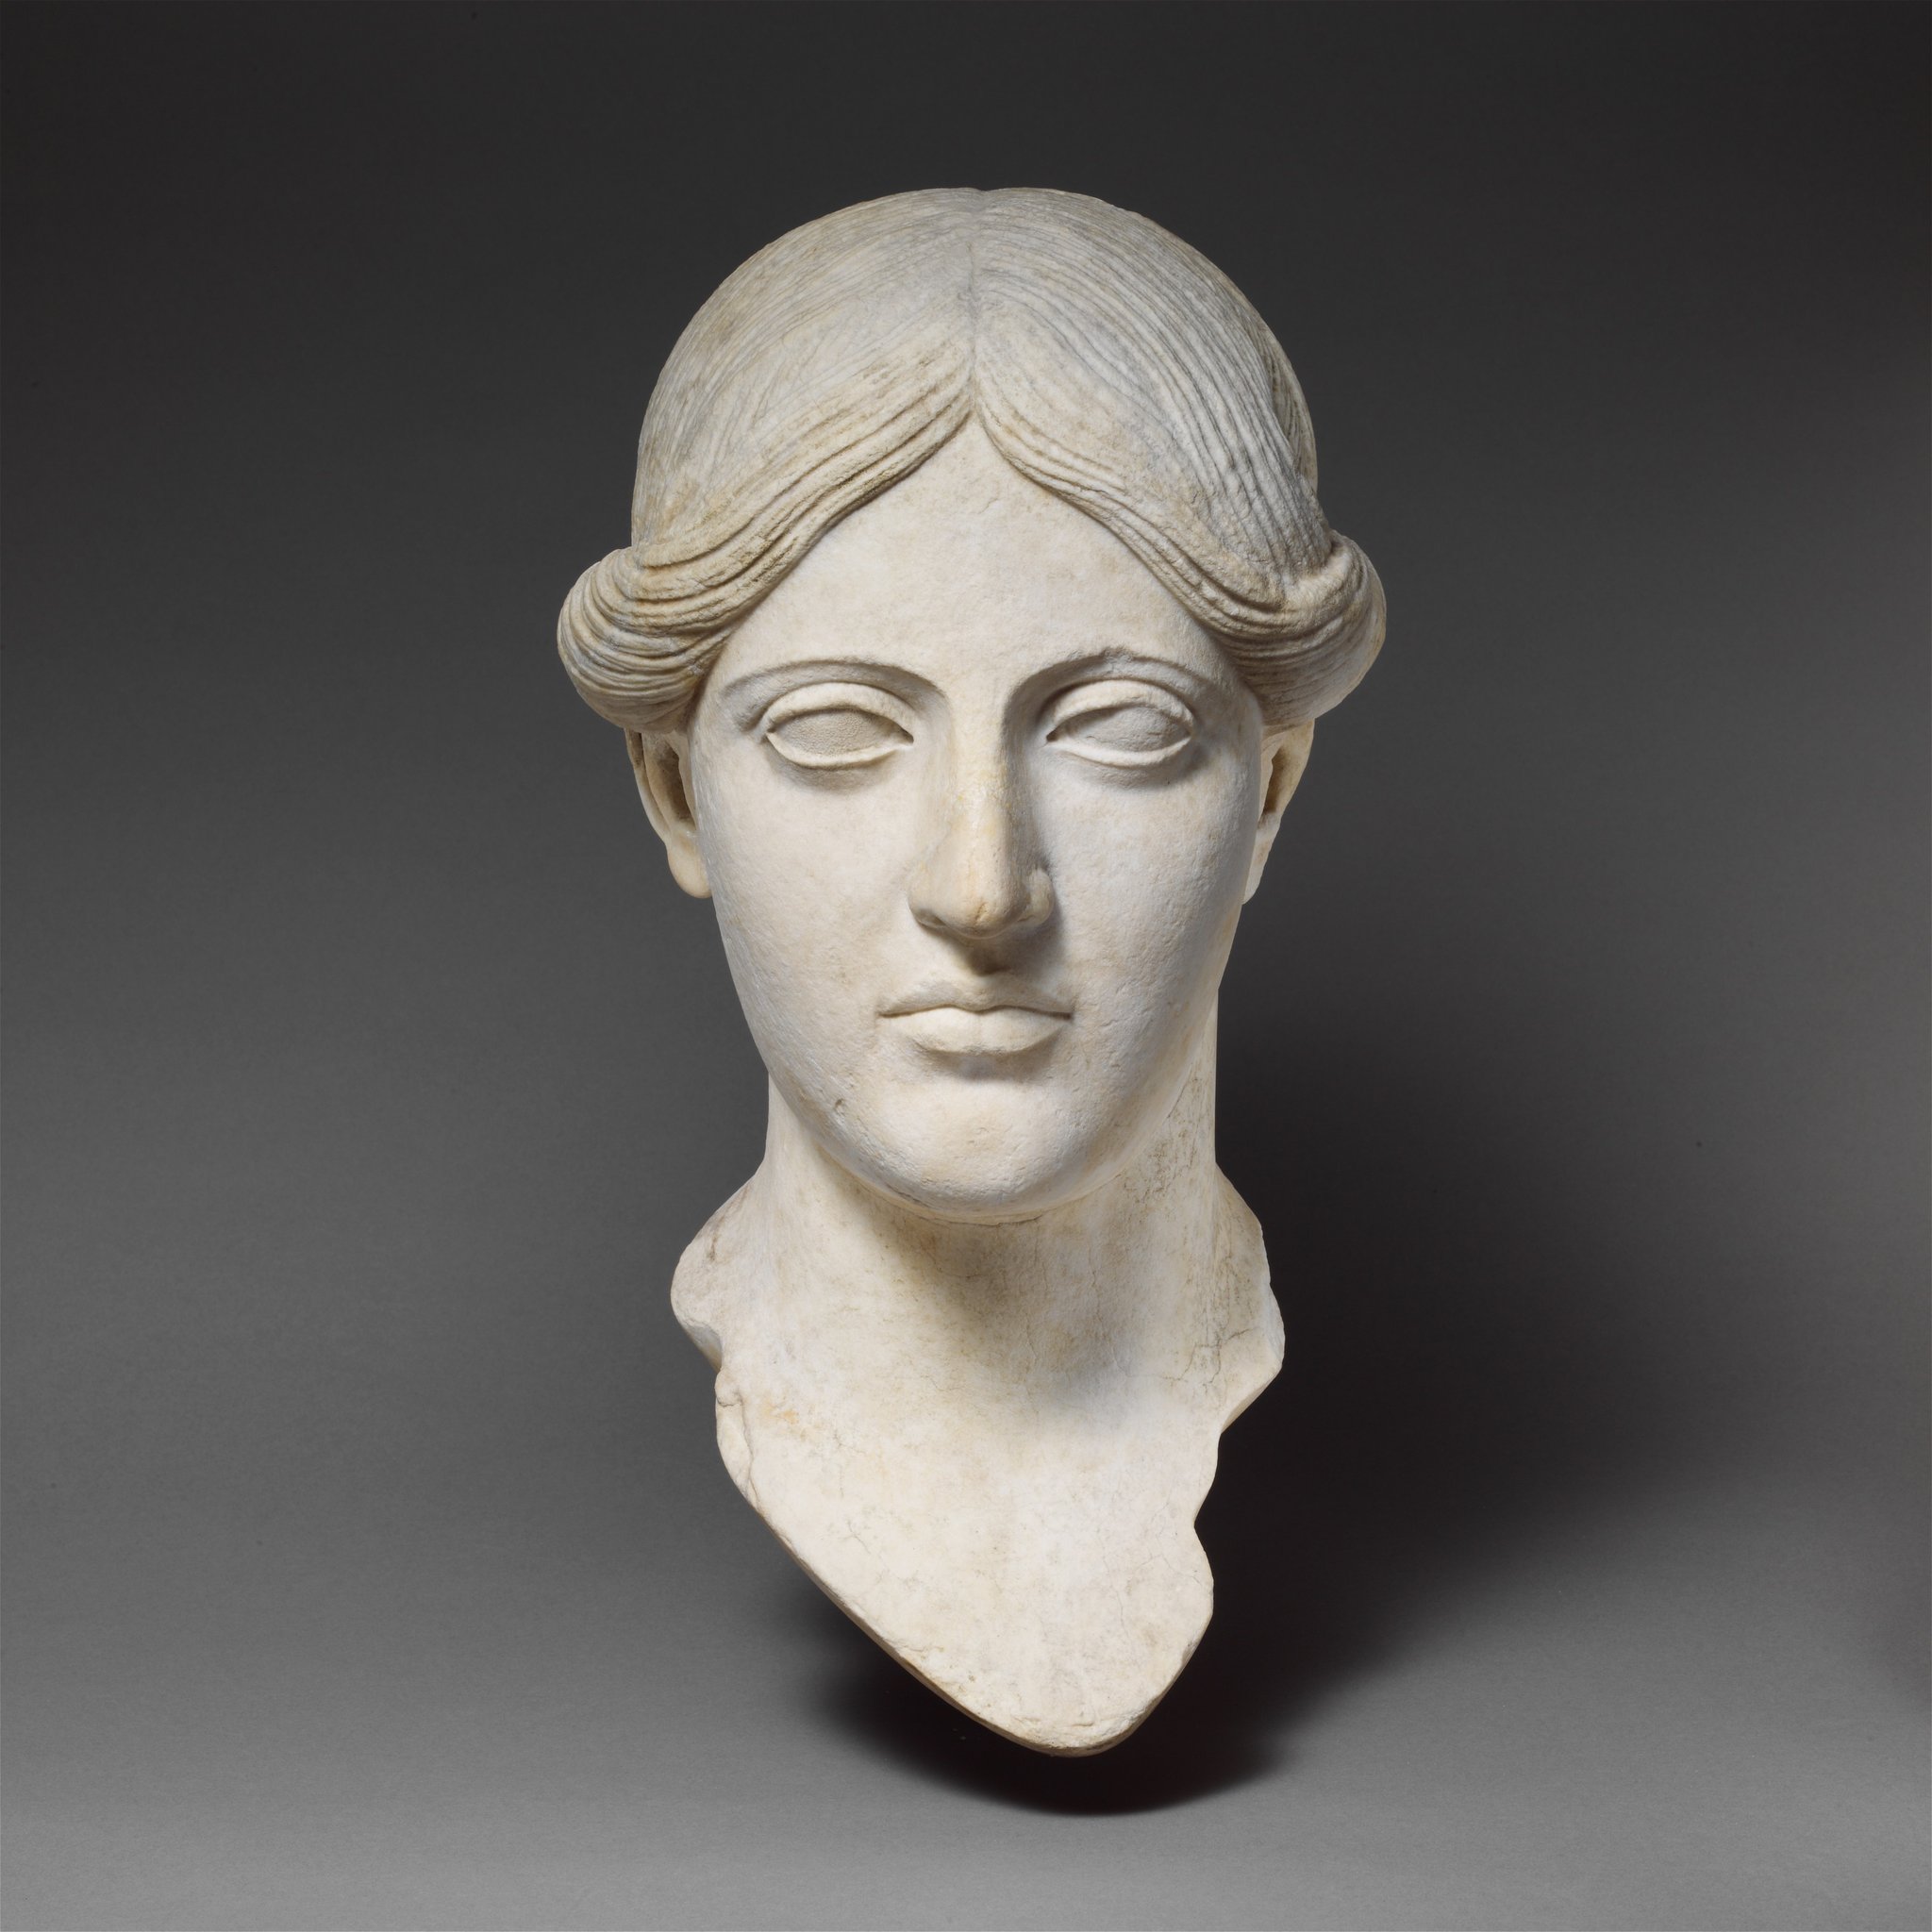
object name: head of a woman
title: Marble head of a woman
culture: roman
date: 1-200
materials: marble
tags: heads,women